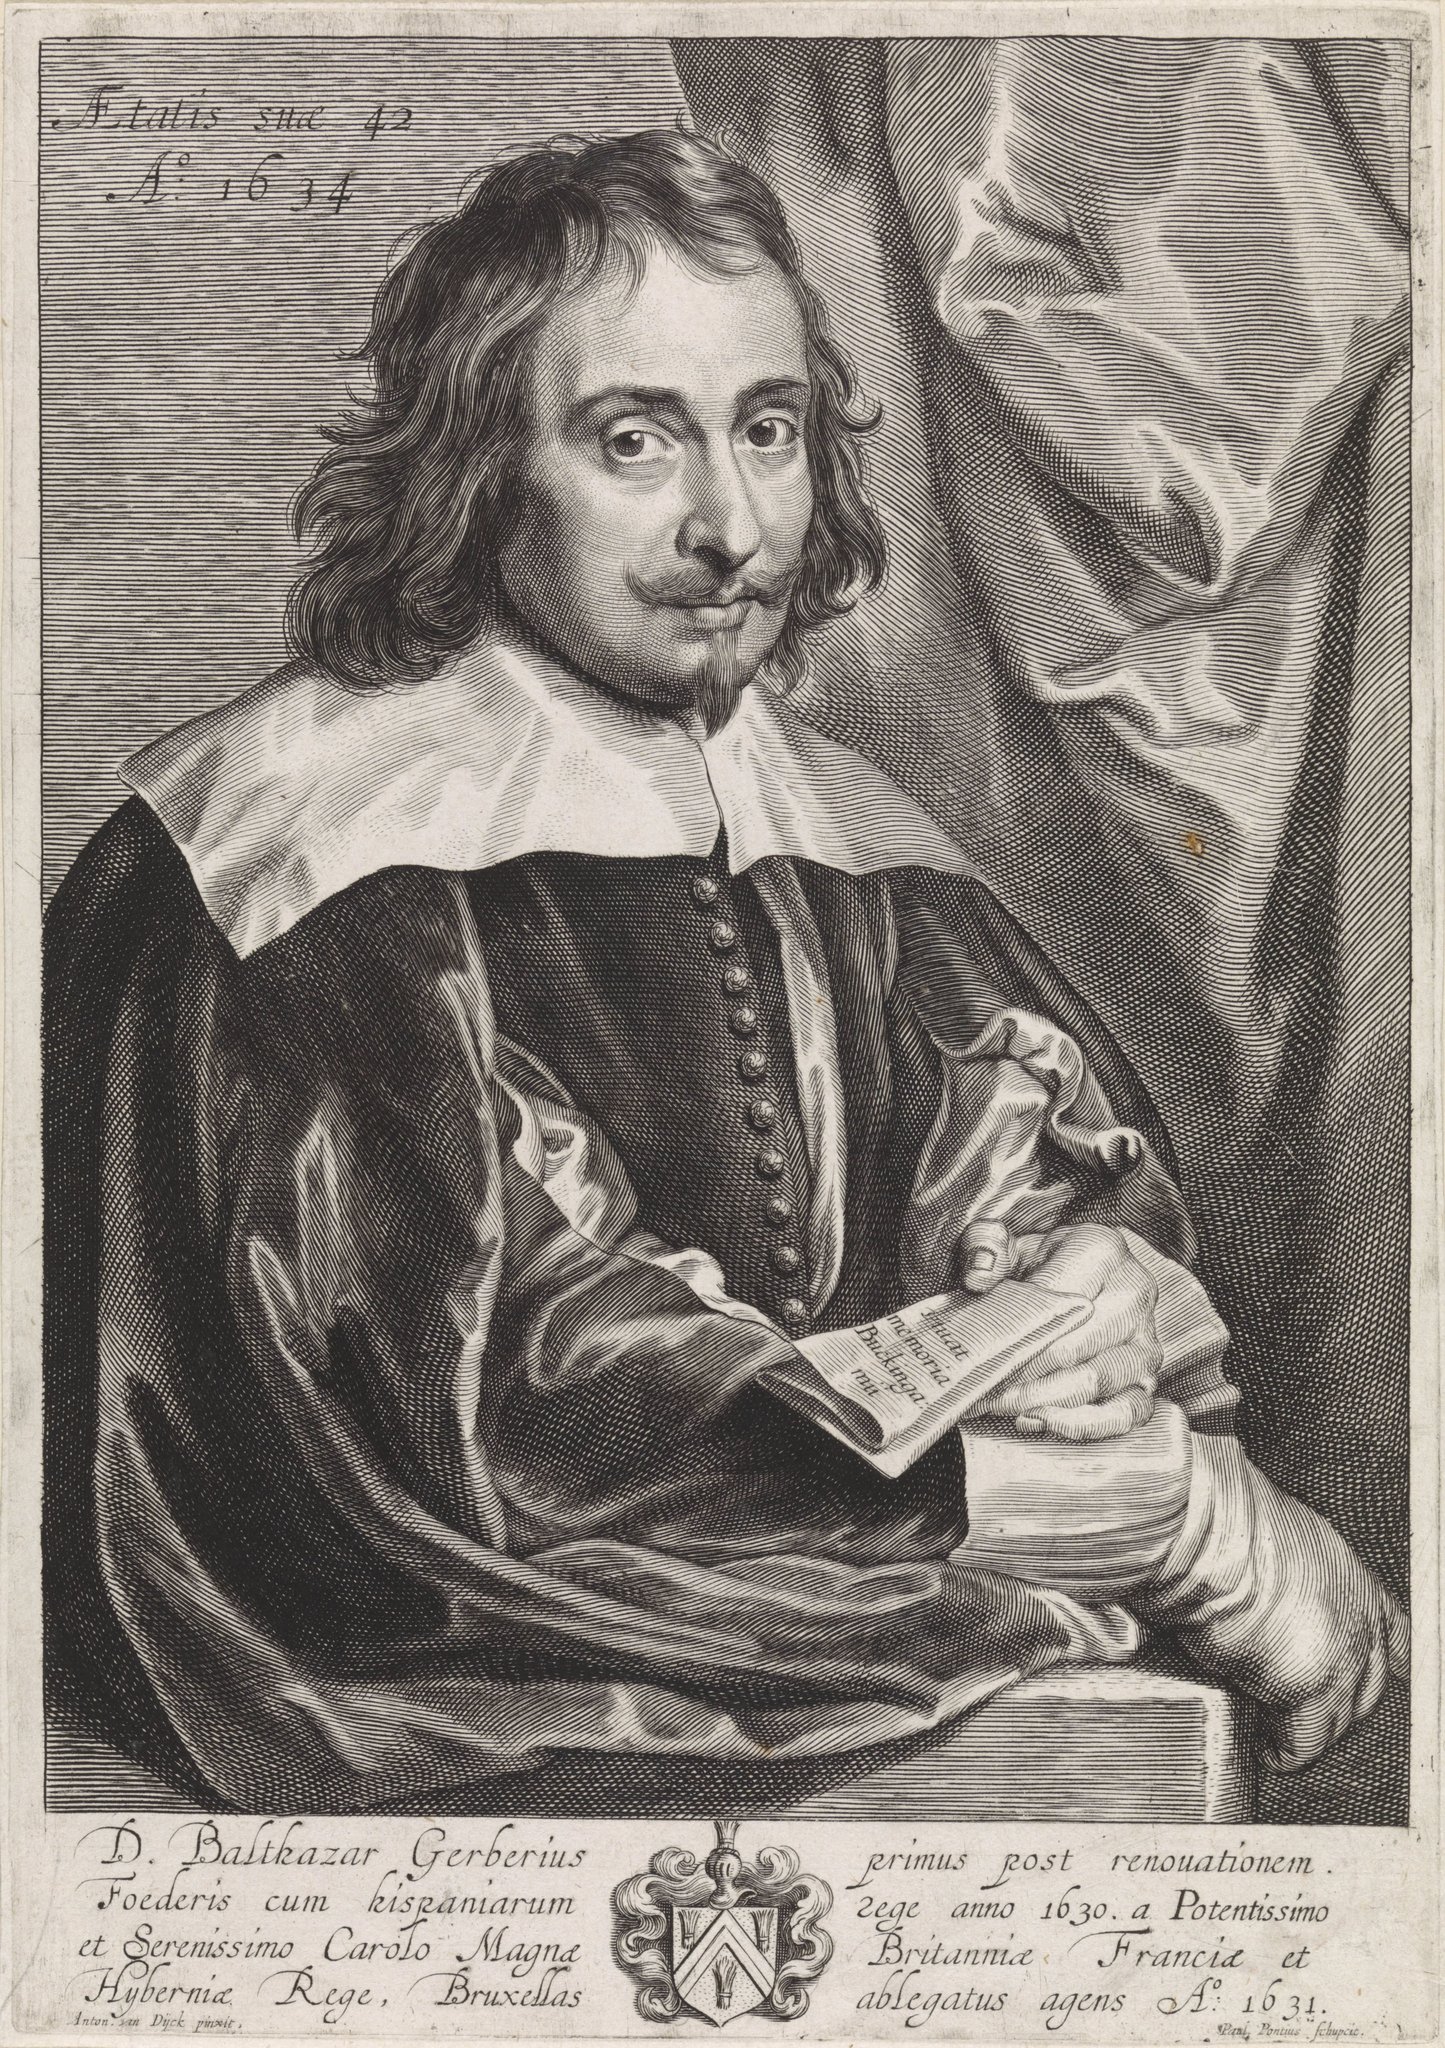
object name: print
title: Portret van Balthasar Gerbier, op 42-jarige leeftijd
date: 1634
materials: paper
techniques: engraving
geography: antwerp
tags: london, balthazar gerbier d'ouvilly, letter, envelope, armorial bearing, heraldry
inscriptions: collector's mark: Lugt 240